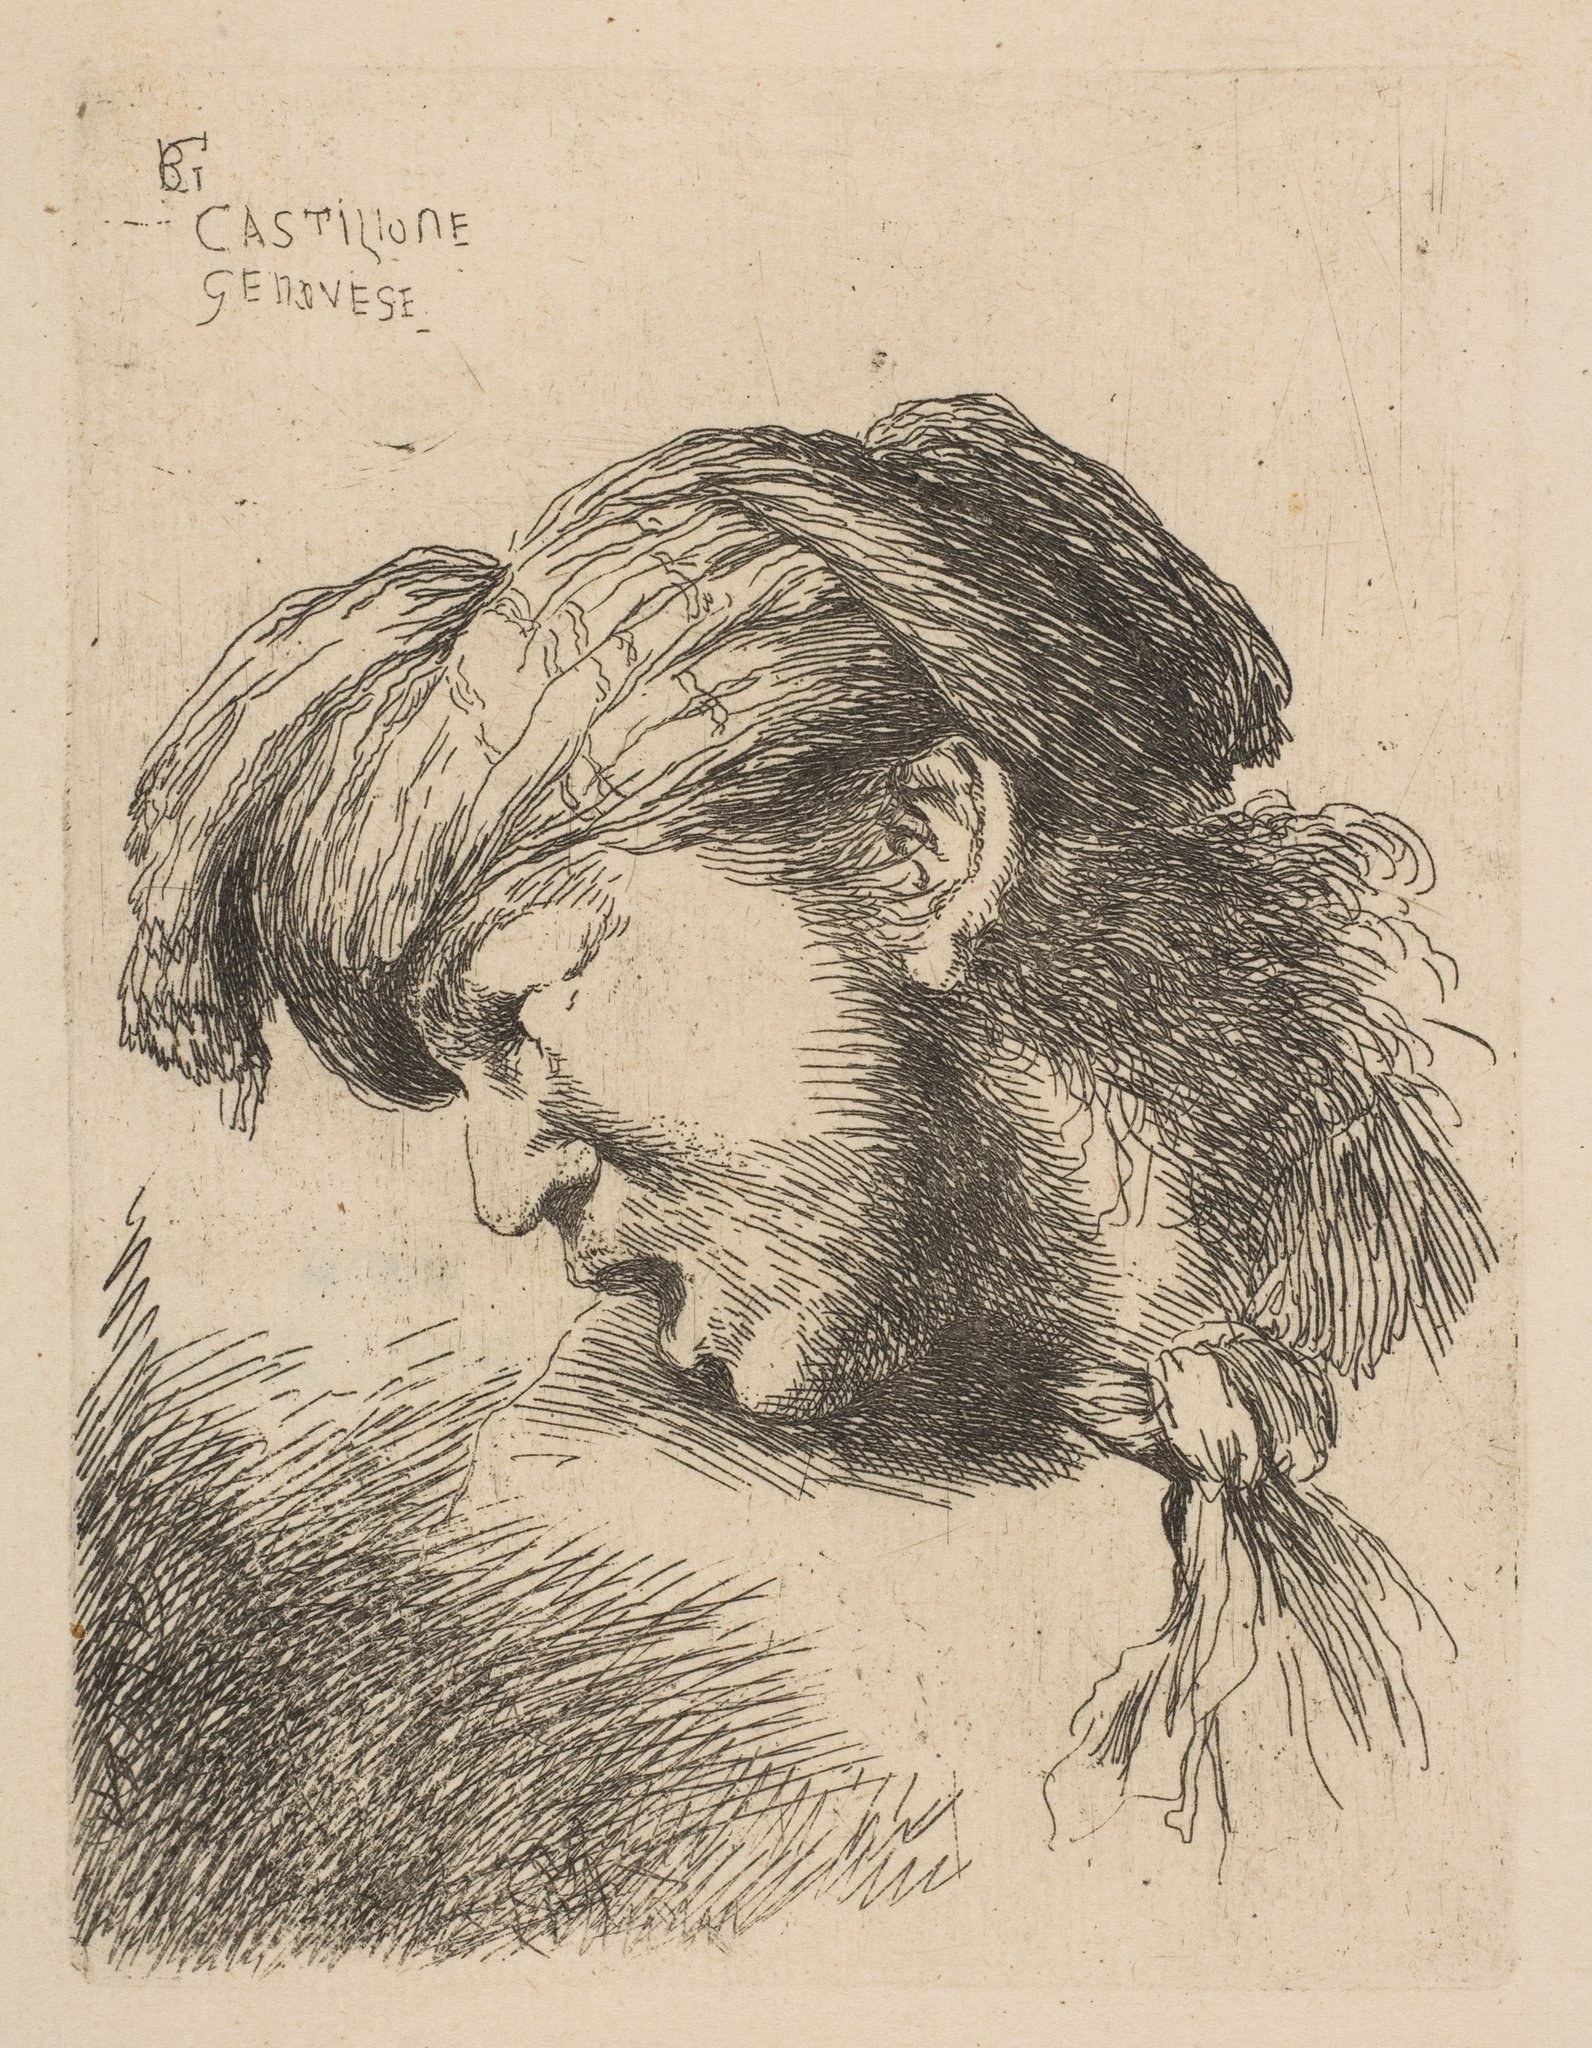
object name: print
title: Man wearing a turban, a tie fastened around his neck, facing left, from "Small Heads in Oriental Headdress"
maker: giovanni benedetto castiglione (il grechetto)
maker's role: artist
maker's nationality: italian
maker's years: 1609-1664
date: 1645-1650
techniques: etching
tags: men,profiles